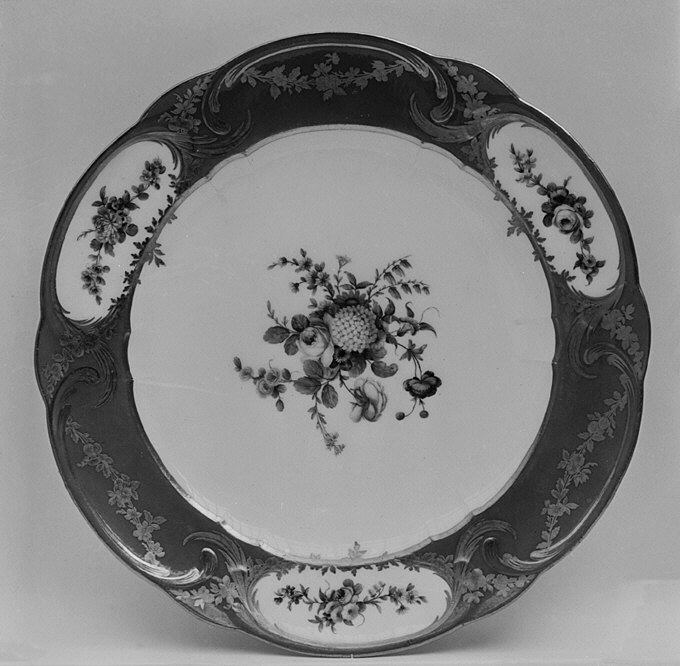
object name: plate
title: Plate (assiette à palmes) (1 of 102) (part of a service)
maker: sèvres manufactory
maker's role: manufactory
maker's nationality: french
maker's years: 1740-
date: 1780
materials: soft paste porcelain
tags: flowers